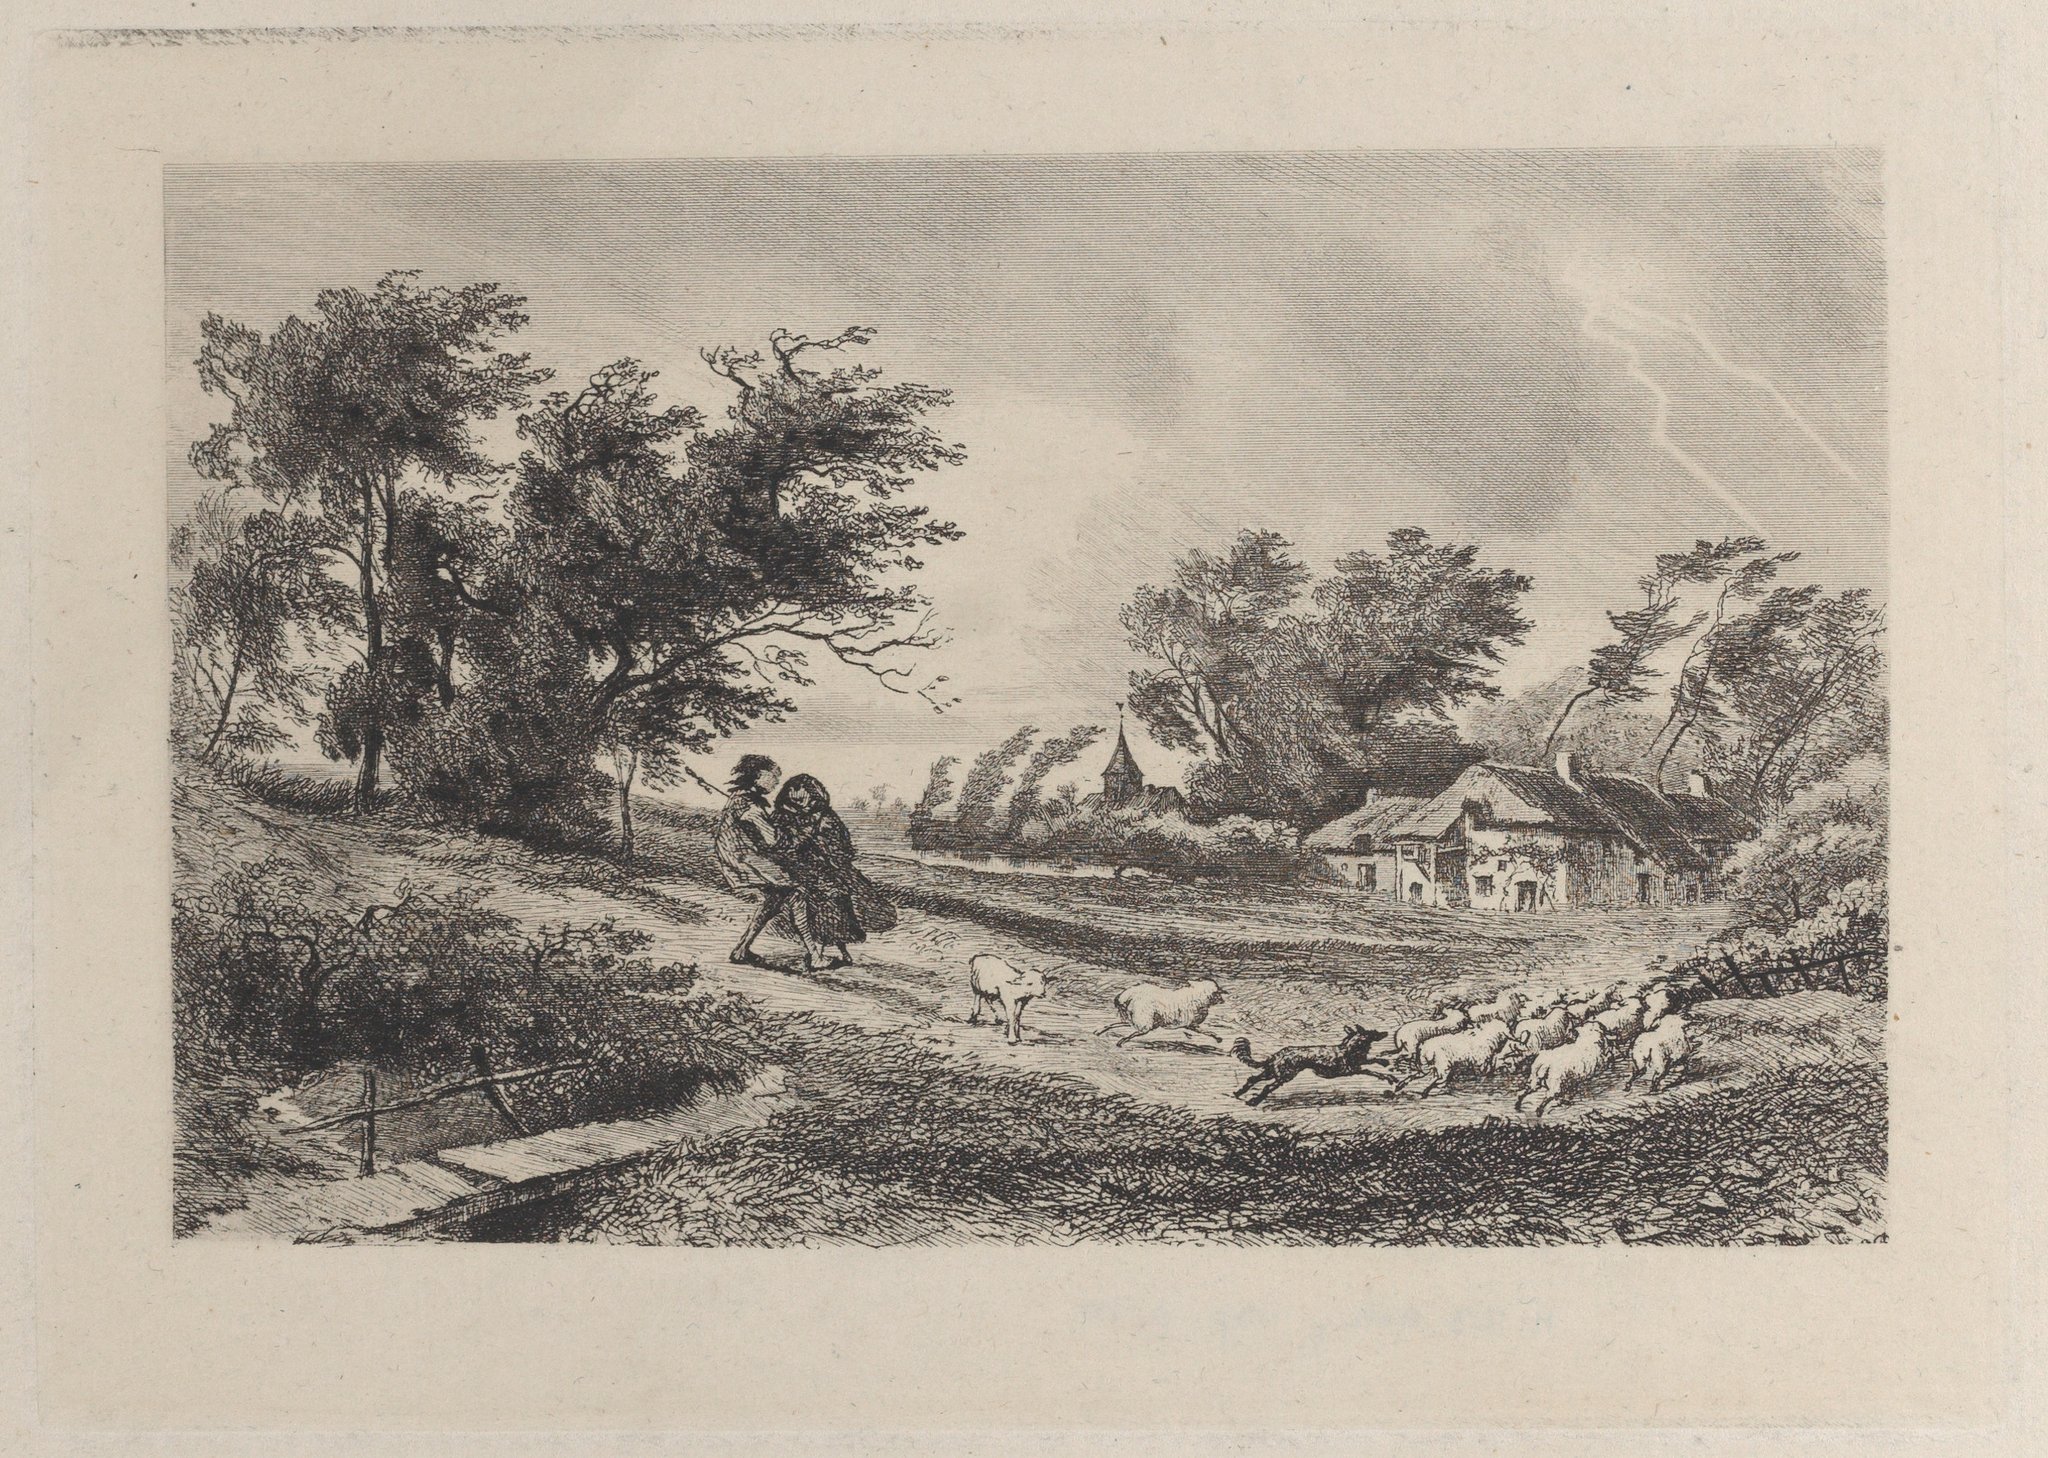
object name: print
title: L'Orage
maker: charles-françois daubigny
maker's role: artist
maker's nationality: french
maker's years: 1817-1878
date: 1842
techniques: photogravure